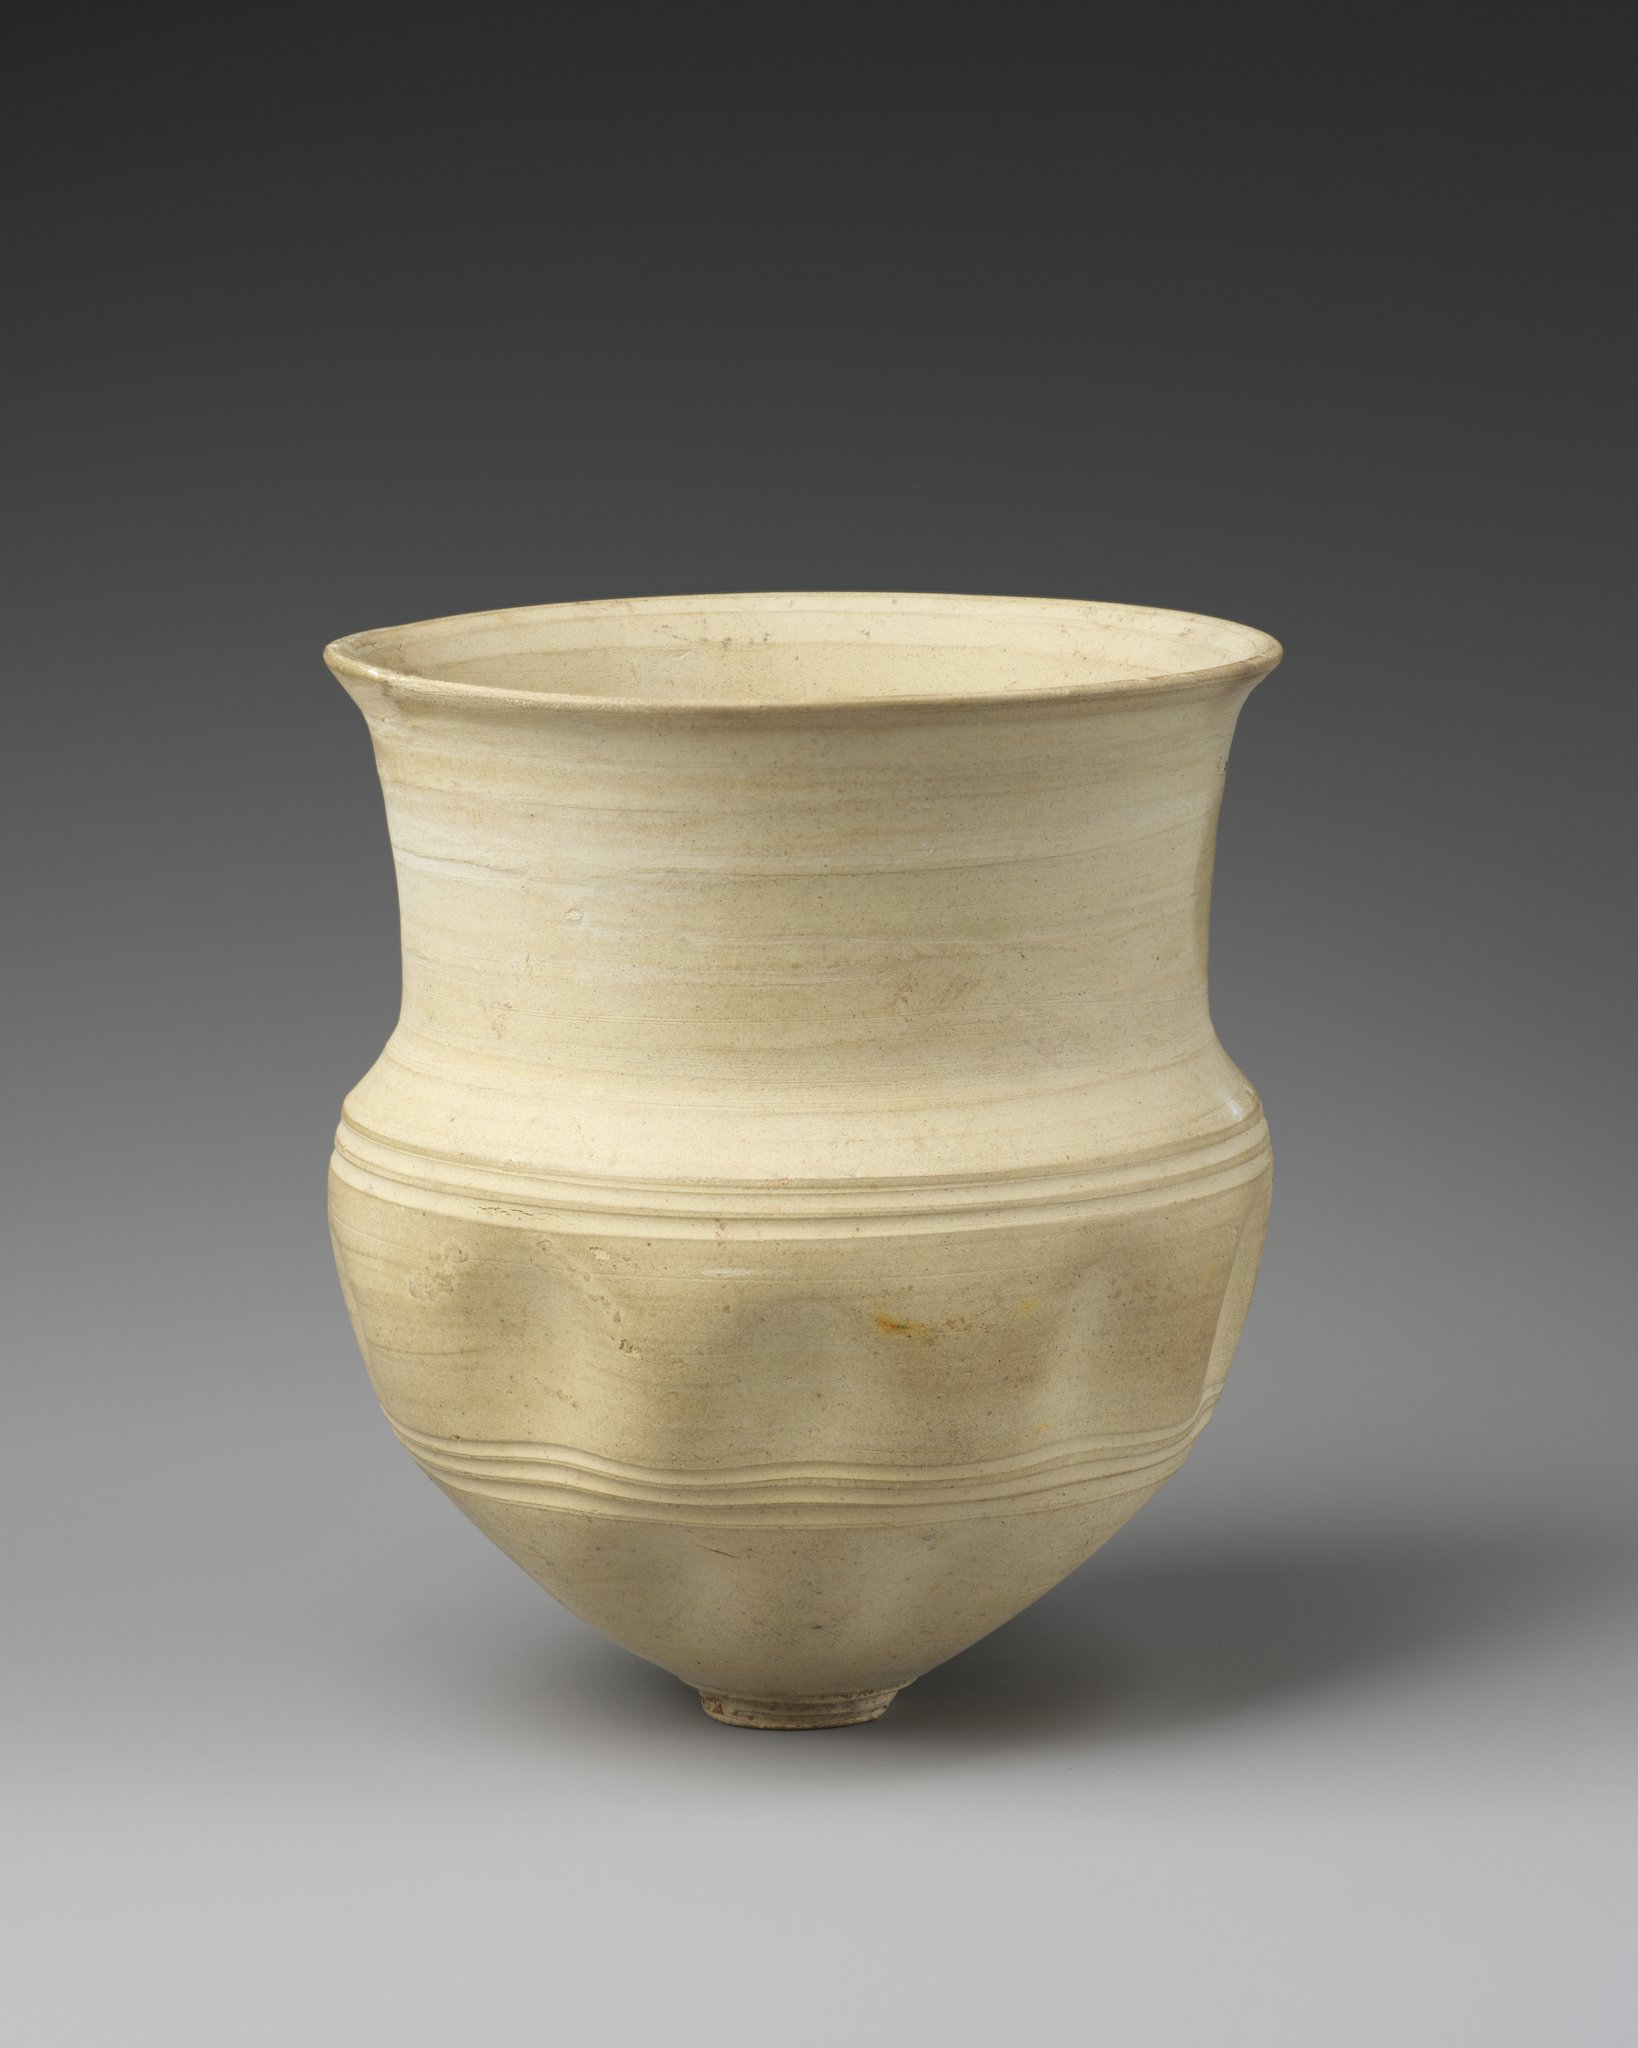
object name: beaker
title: Palace Ware beaker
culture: assyrian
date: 700-601 BCE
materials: ceramic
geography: mesopotamia